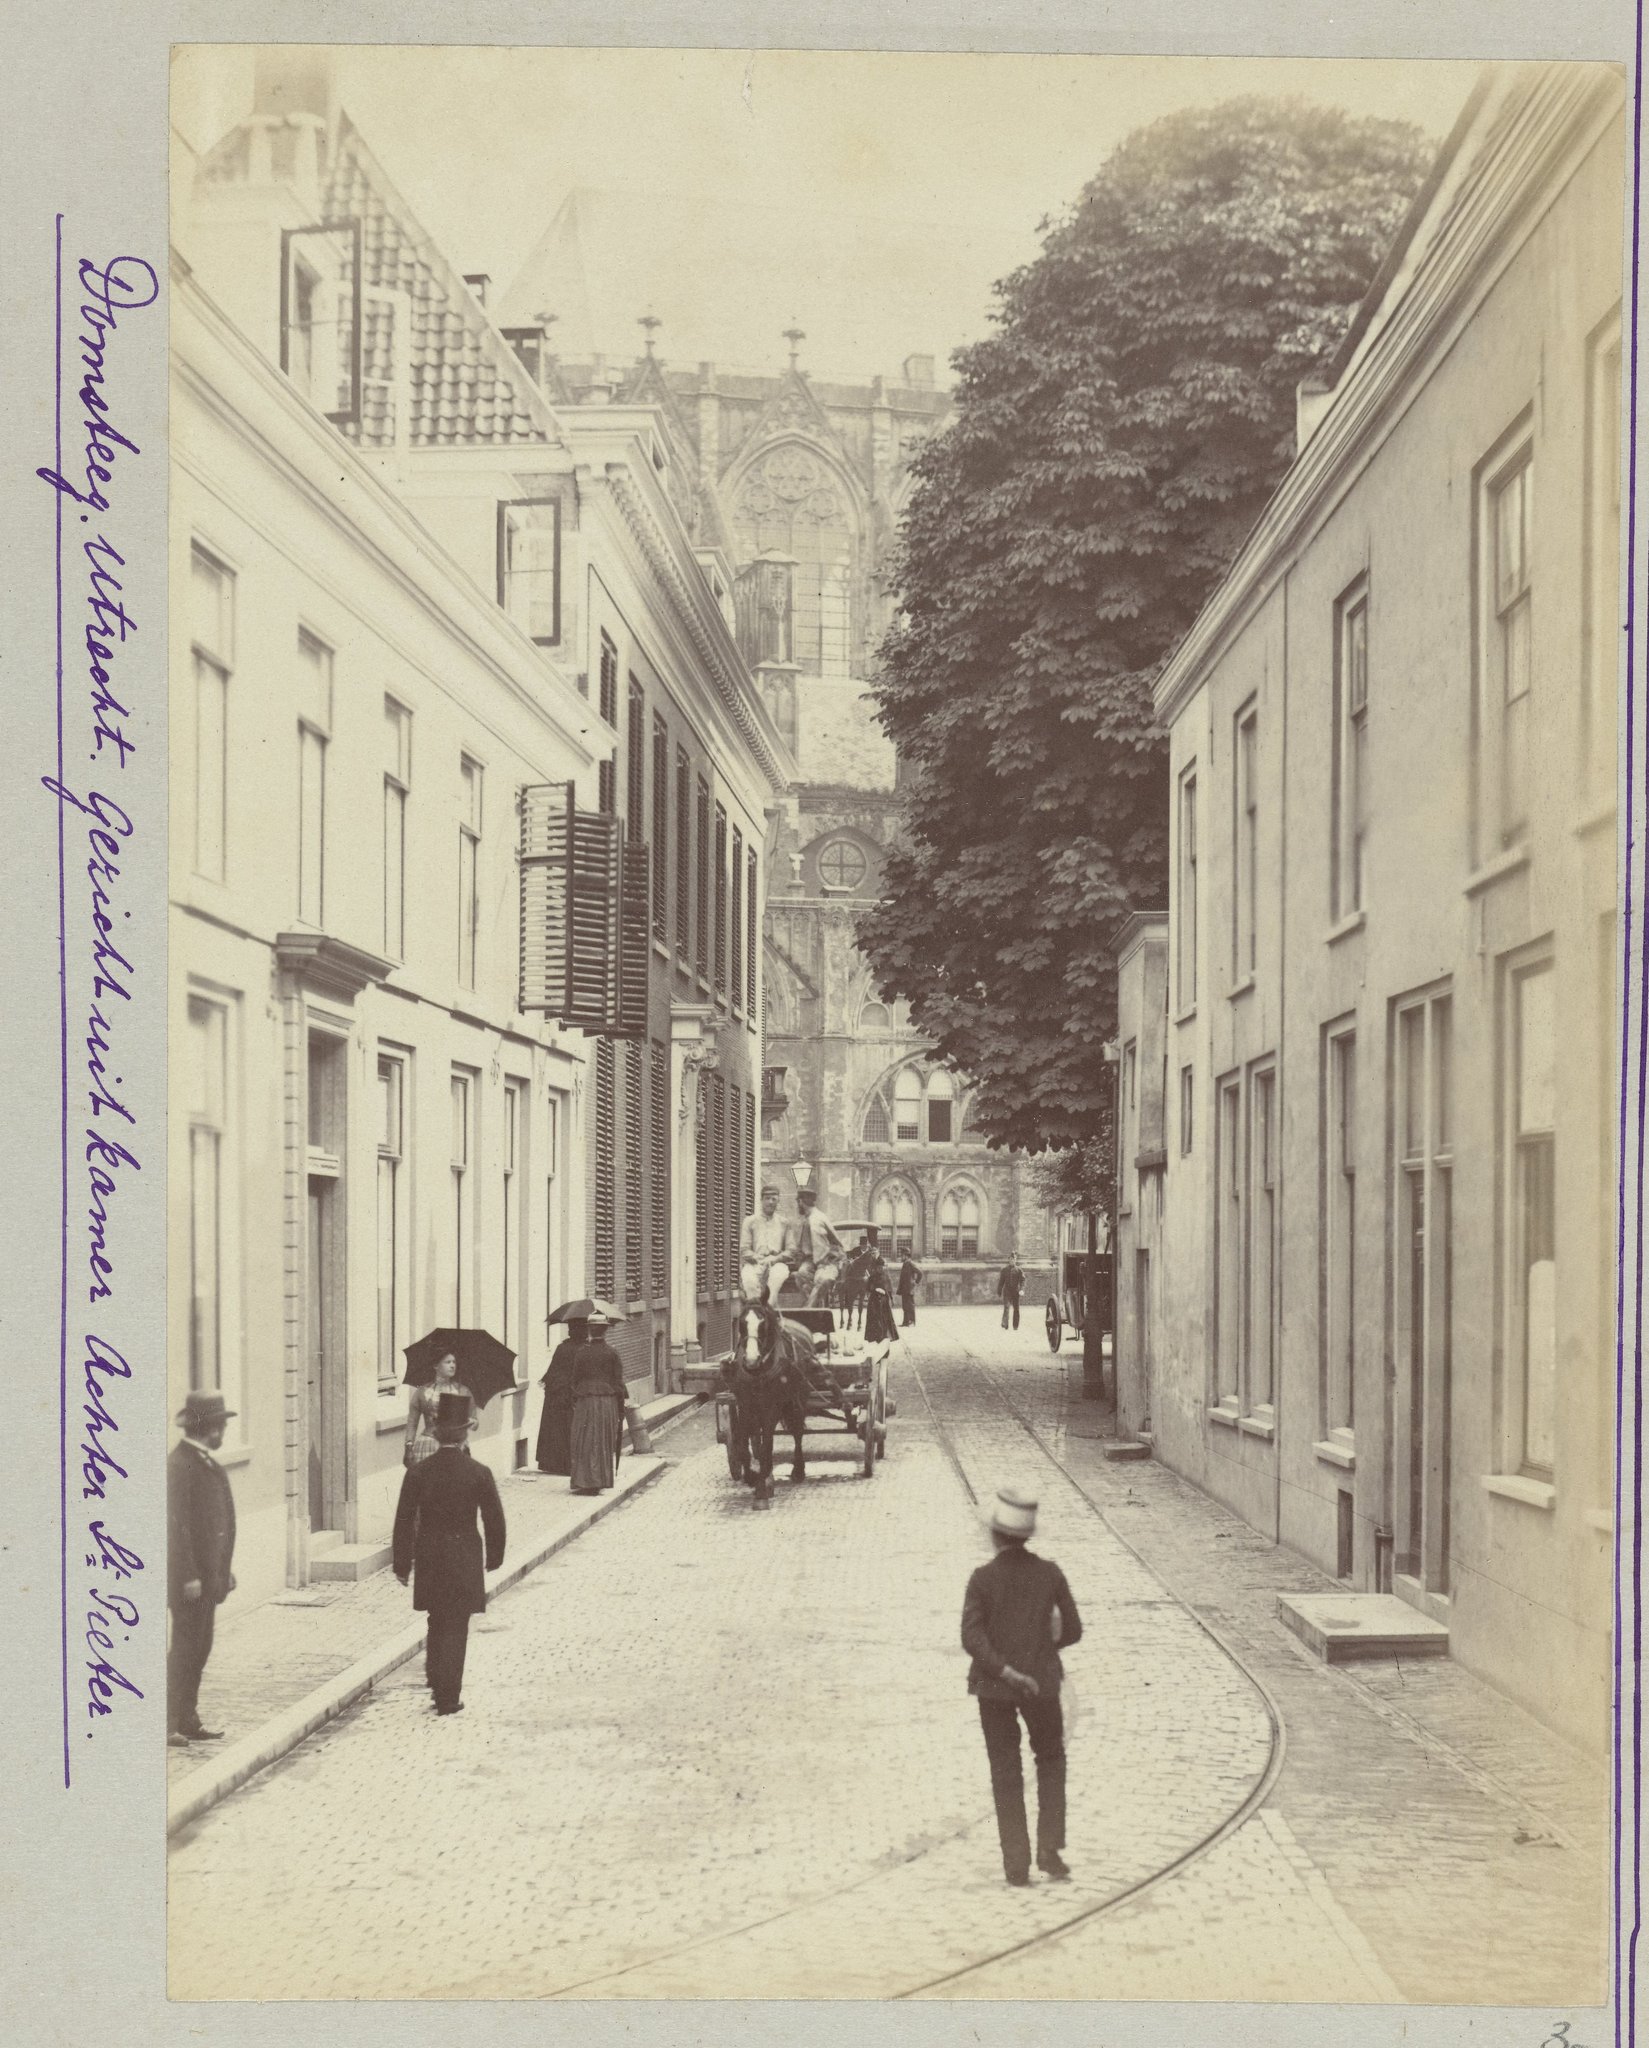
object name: photograph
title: Domstraat in Utrecht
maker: henry pauw van wieldrecht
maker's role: fotograaf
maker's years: 1863-1912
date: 1888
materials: paper, photographic support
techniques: albumen print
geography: netherlands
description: De Domstraat in Utrecht, met door de straat een tramrails en wandelende mensen. Met zijschrift: Domsteeg. Utrecht, gezicht uit kamer achter St. Pieter.